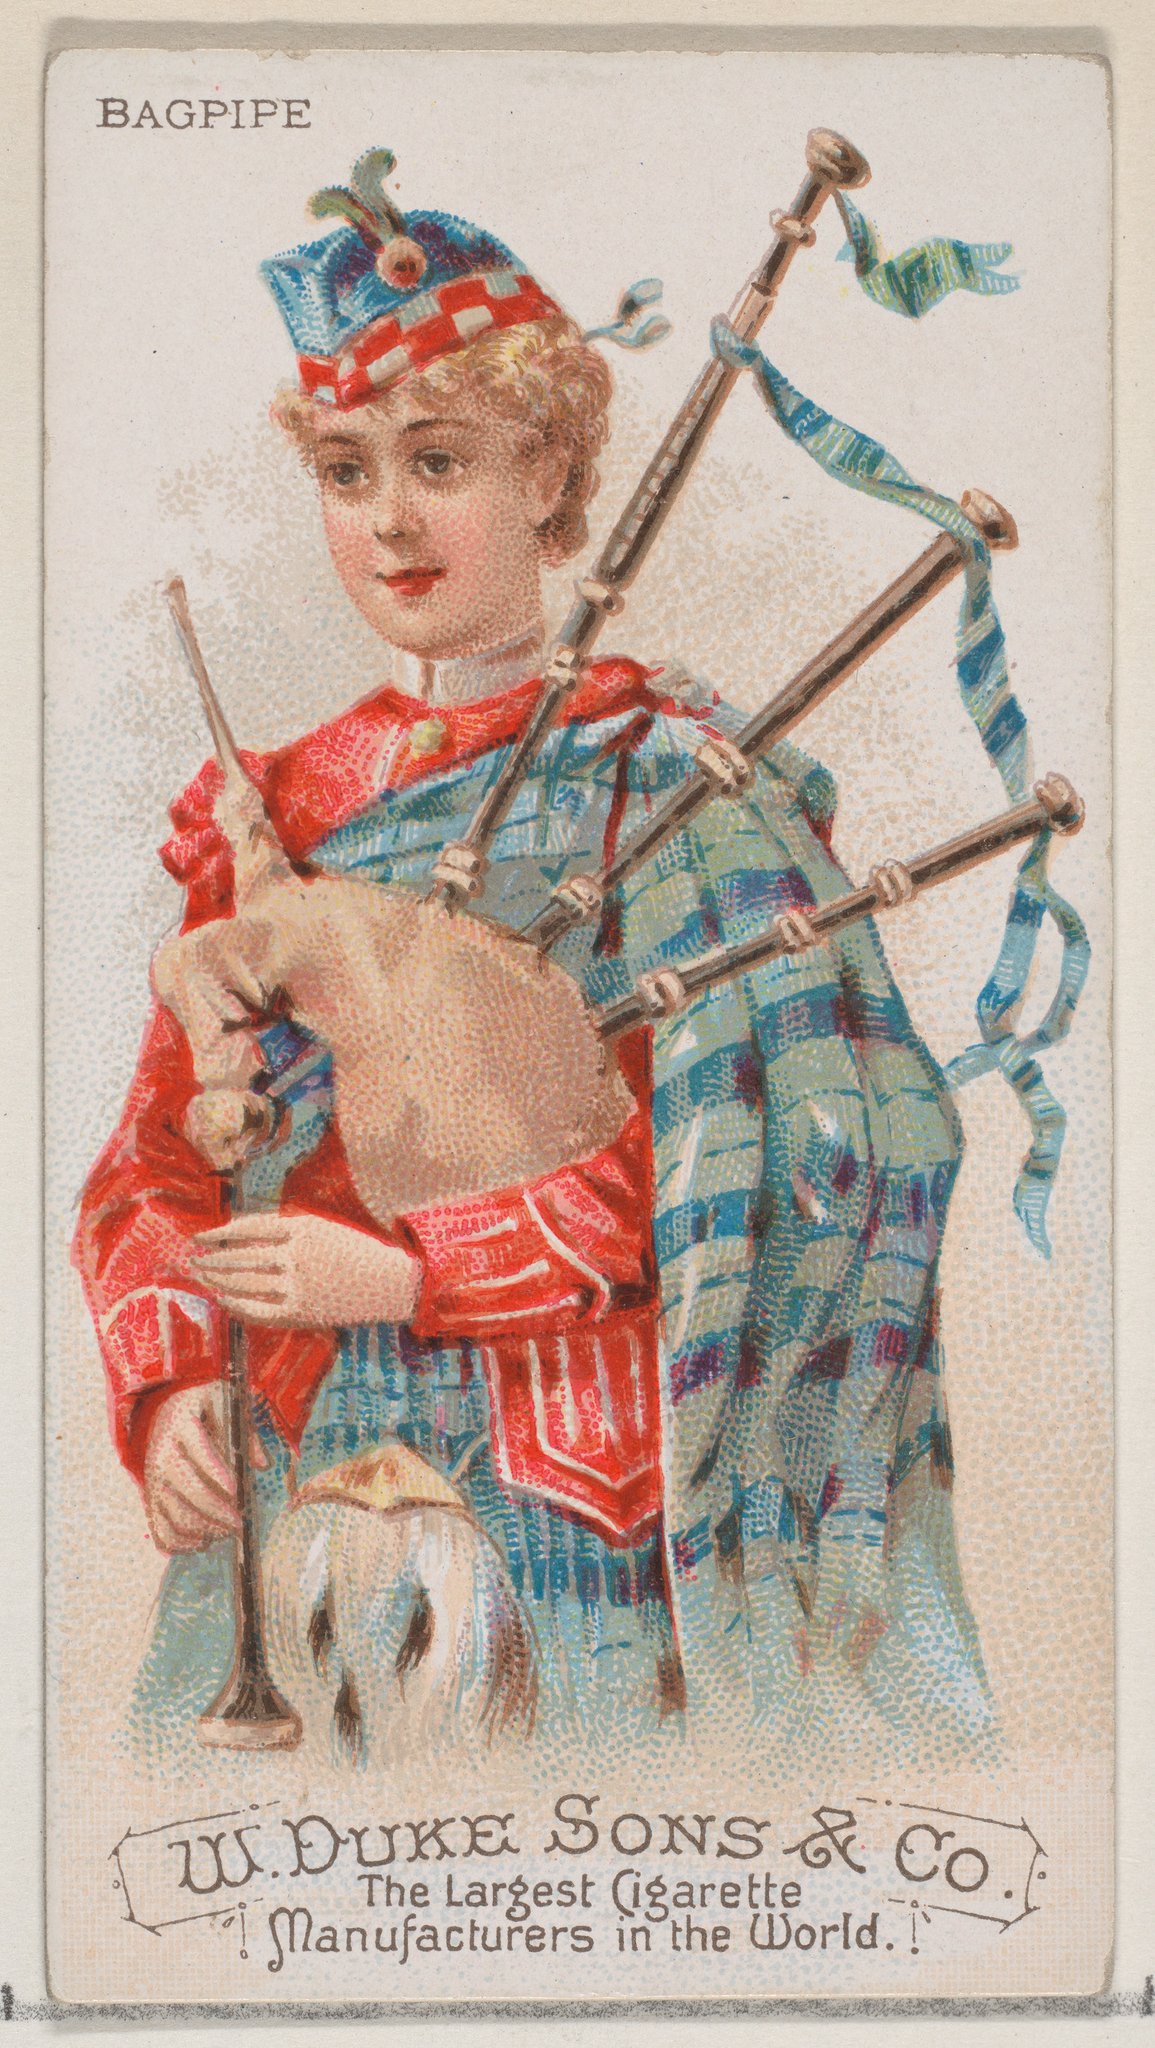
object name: print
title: Bagpipe, from the Musical Instruments series (N82) for Duke brand cigarettes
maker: w. duke, sons & co.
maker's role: publisher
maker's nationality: american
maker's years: 1870-1920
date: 1888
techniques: color lithograph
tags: women,bagpipes,musicians